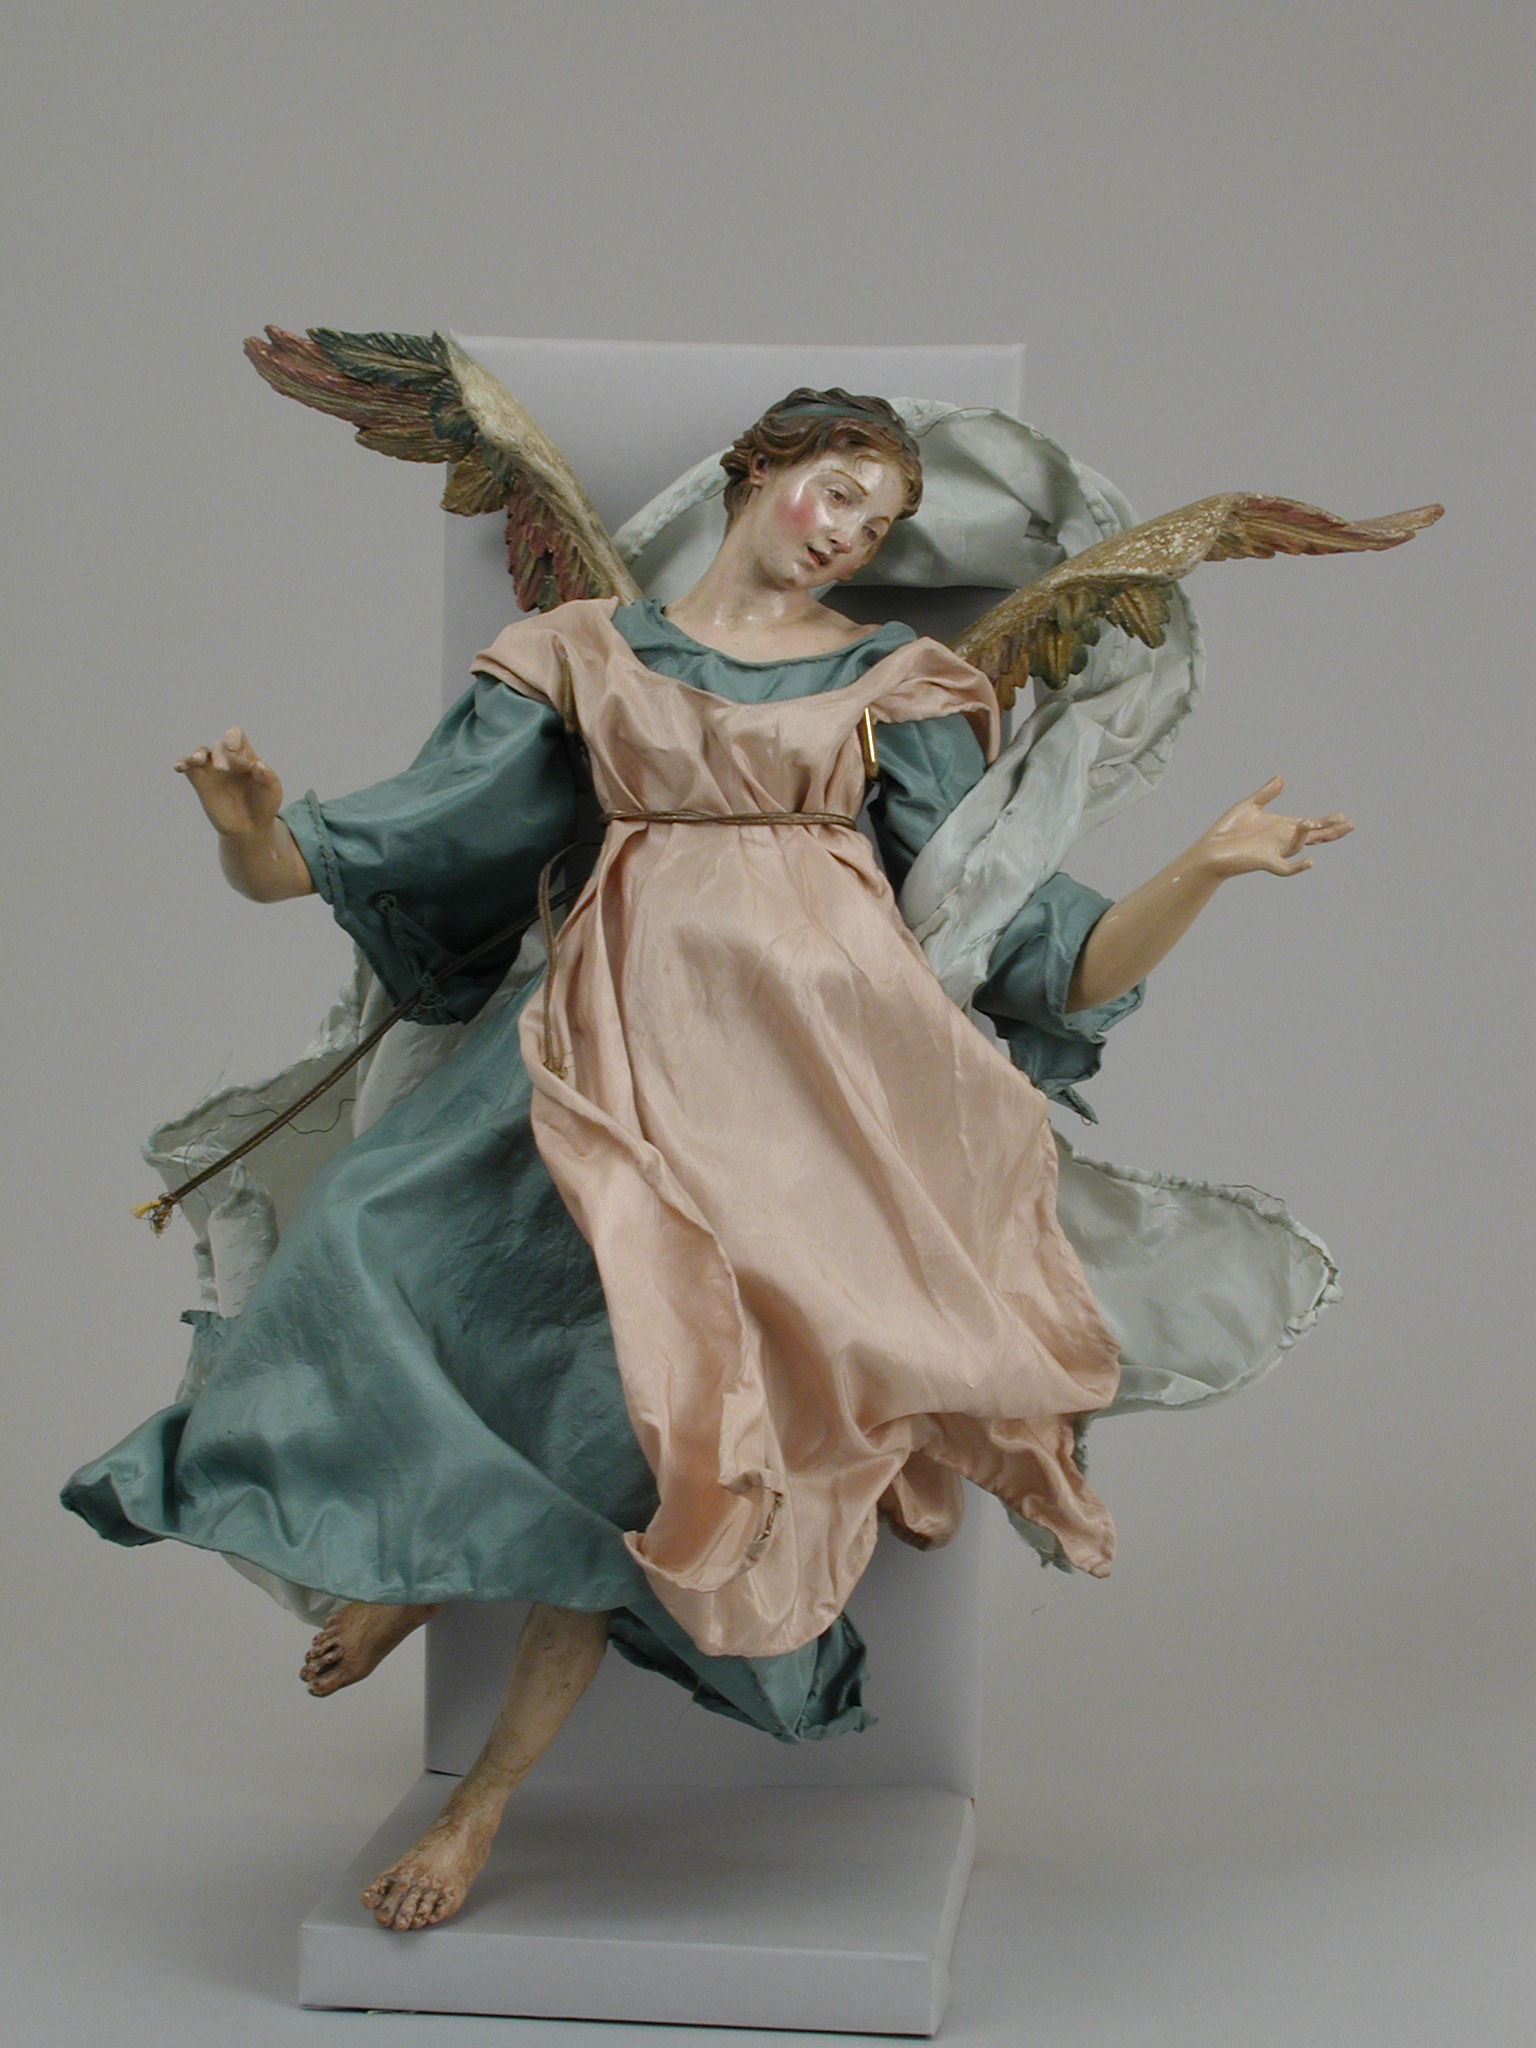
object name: crèche figure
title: Angel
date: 1751-1800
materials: terracotta, fiber, metal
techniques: polychrome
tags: angels